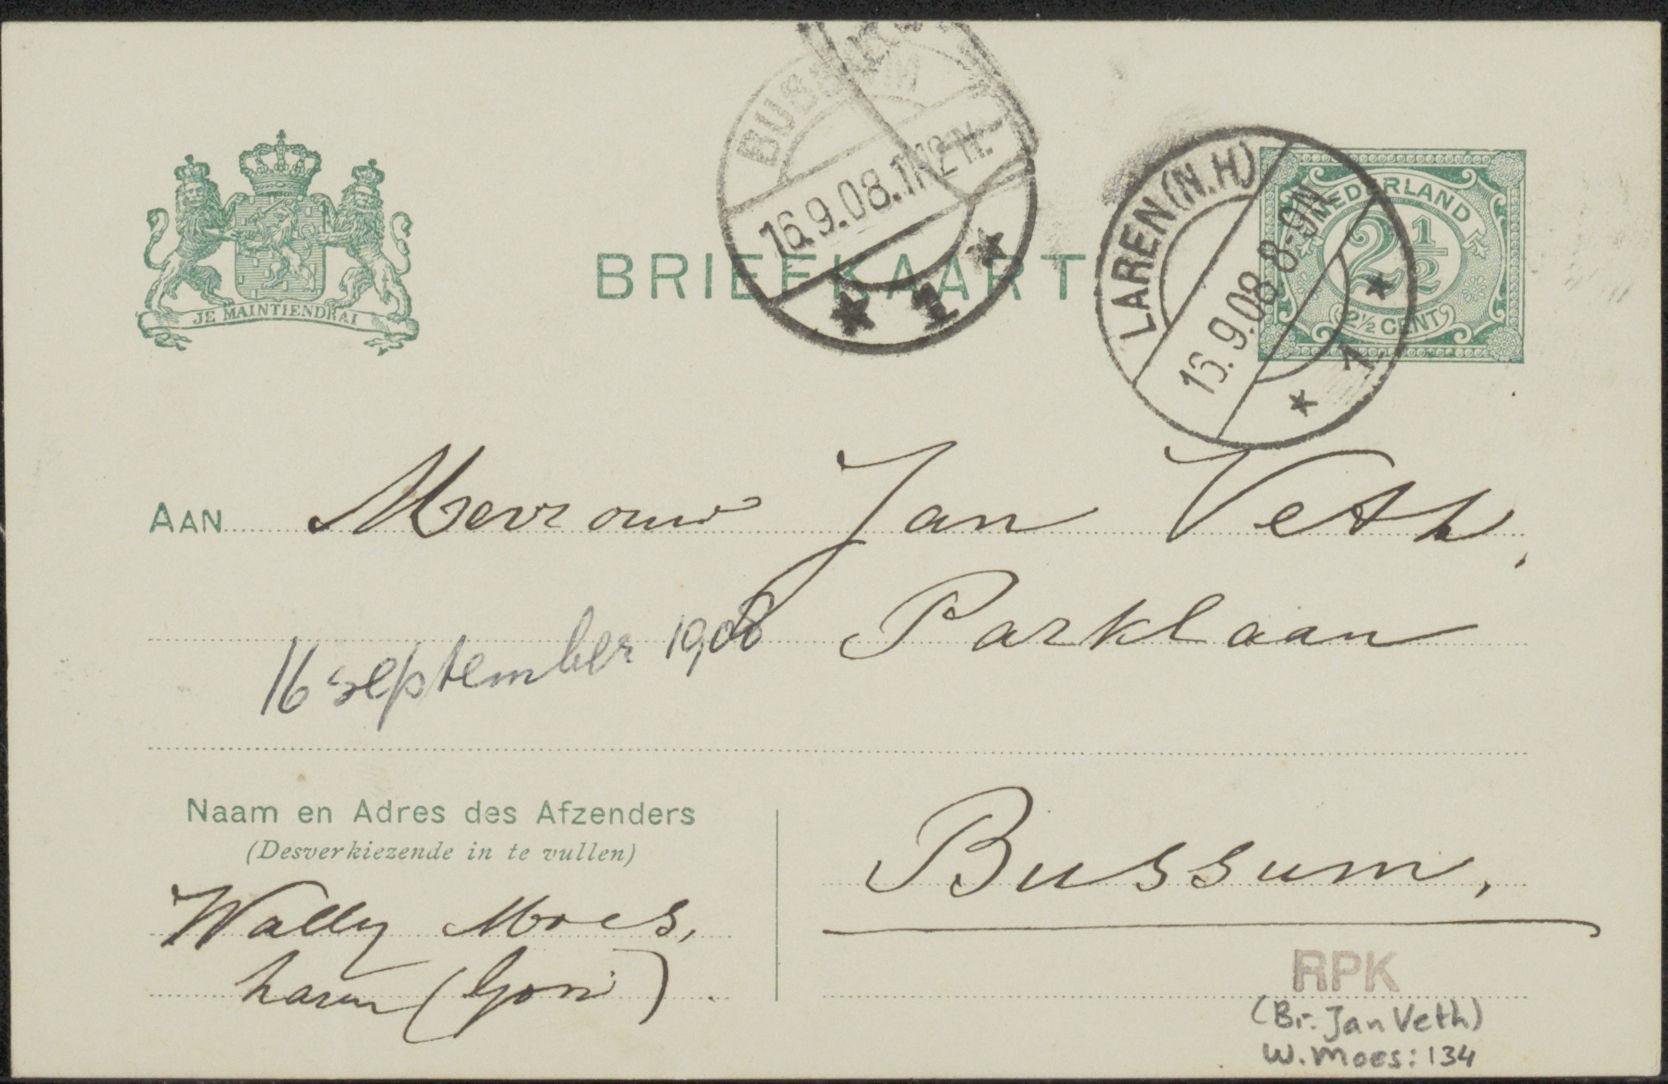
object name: postcard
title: Briefkaart aan Anna Dorothea Dirks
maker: wally moes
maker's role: draughtsman, print maker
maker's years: 1856-1918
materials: cardboard, ink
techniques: pen, writing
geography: laren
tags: artist, anna dorothea dirks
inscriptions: collector's mark: ‘RPK’